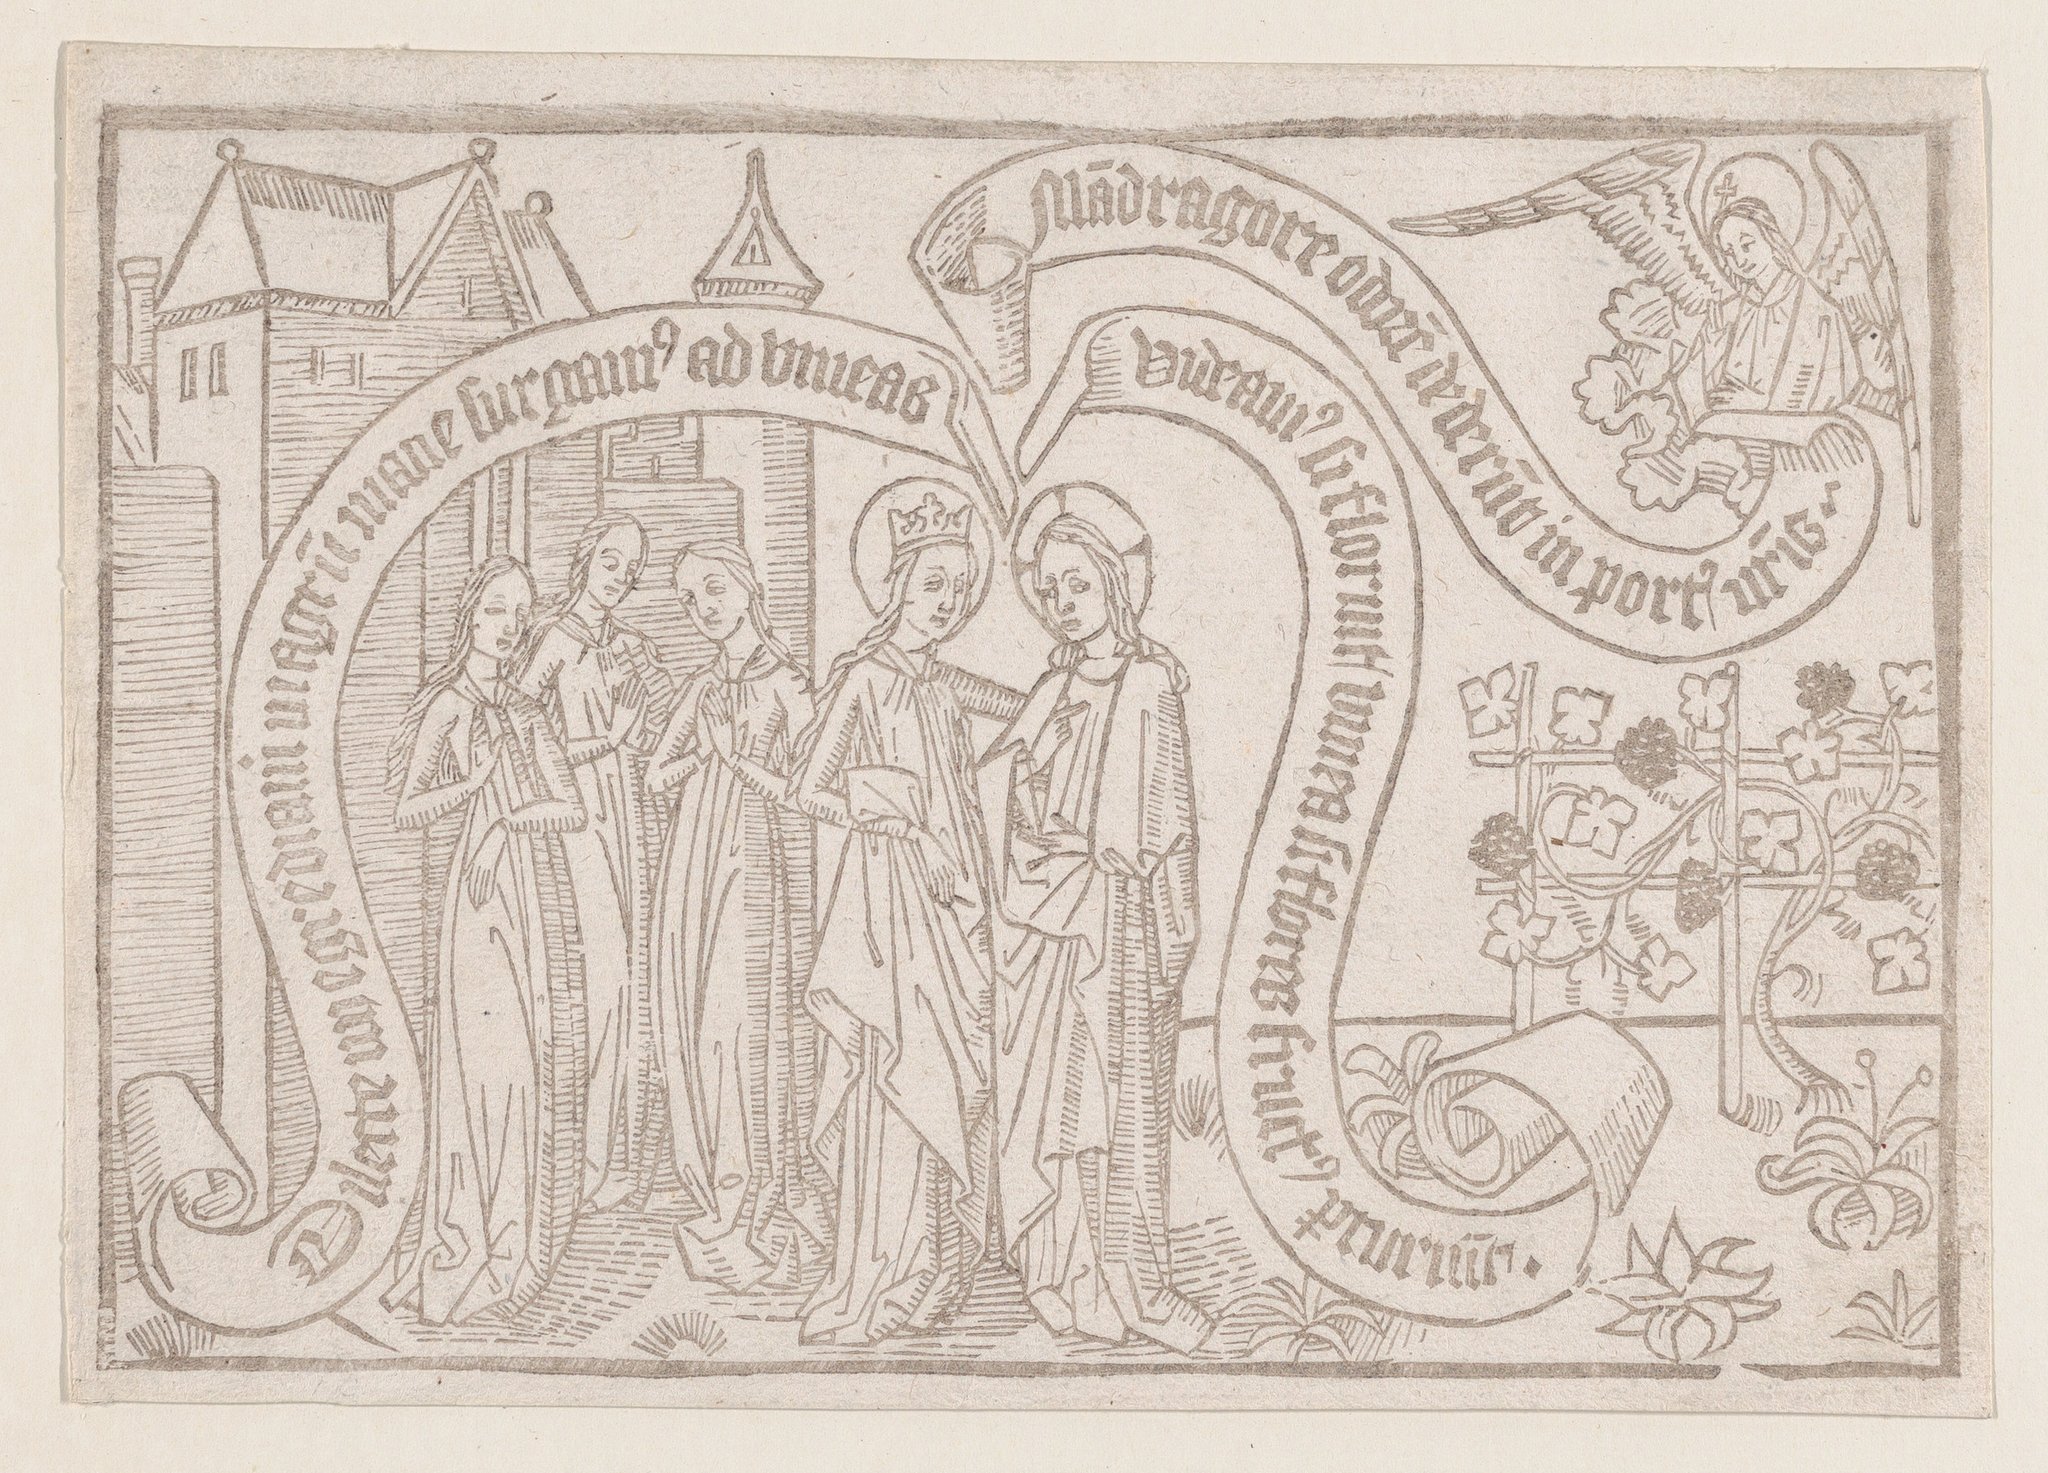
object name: print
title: Come My Beloved, Let Us Go Forth Into the Field, illustration from a Canticum Canticorum blockbook, 2nd edition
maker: anonymous, netherlandish, 15th century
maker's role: artist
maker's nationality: netherlandish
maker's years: 1400-1500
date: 1465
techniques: printing, woodcut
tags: men,women